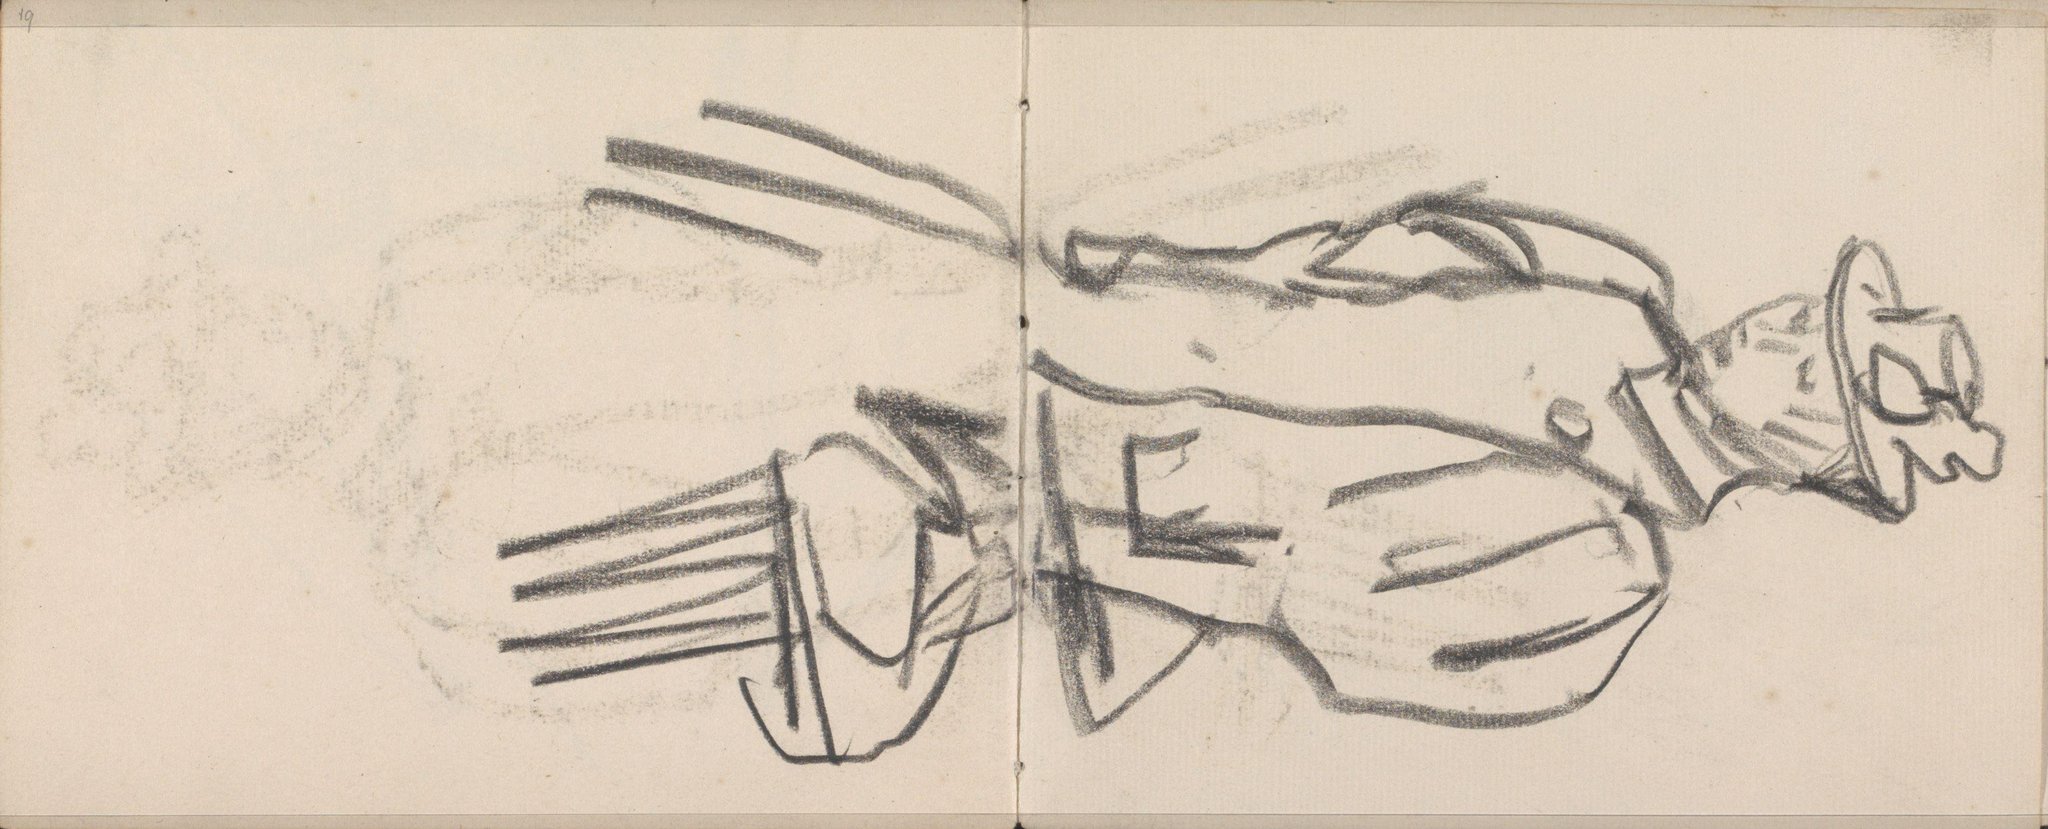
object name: sketchbook leaf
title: Staande vrouw met hoed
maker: george hendrik breitner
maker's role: draughtsman, painter, print maker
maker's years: 1857-1923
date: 1886-1891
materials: chalk, paper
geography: amsterdam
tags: adult woman, head-gear: hat (+ women's clothes)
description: Pagina 19 en pagina 20 uit een schetsboek met 32 bladen.